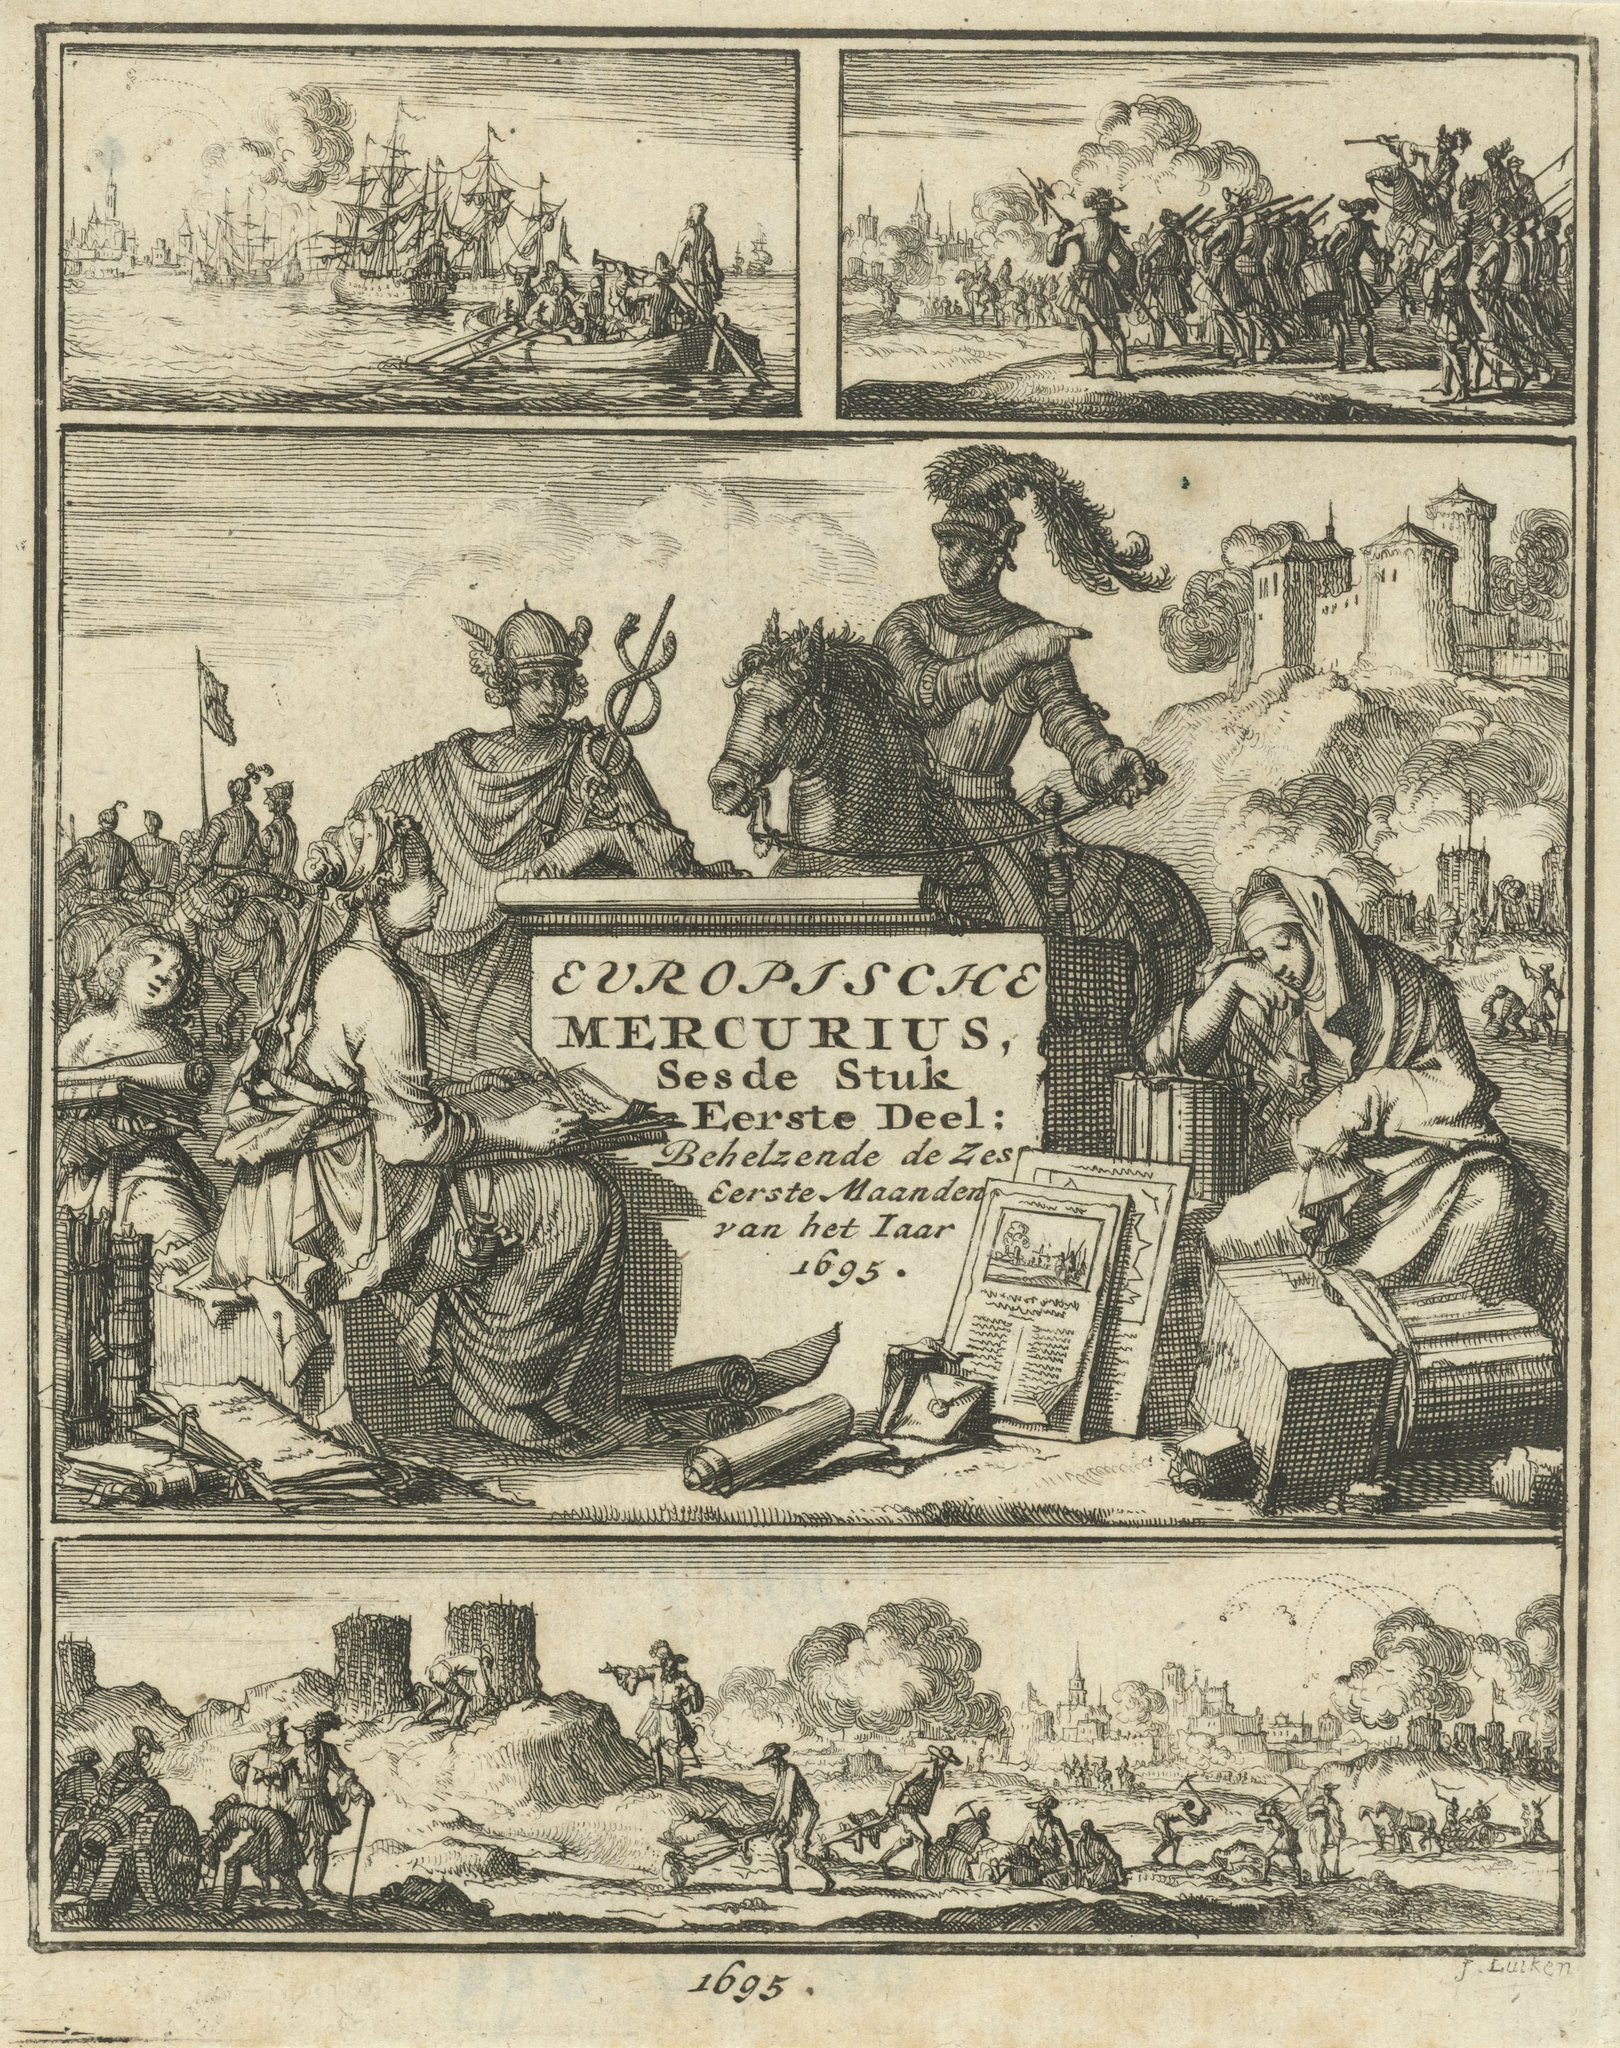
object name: print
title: Titelpagina voor: Europische Mercurius, Sesde Stuk, Eerste Deel: Behelzende de ses Eerste Maenden van het Jaer 1695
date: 1695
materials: paper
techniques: etching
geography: amsterdam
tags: author, poet writing (+ writing), riding a horse, ass, or mule; rider, horseman, (story of) mercury (hermes), attack ~ siege, pain, sorrow, sadness; 'dolore', 'dolore di zeusi' (ripa)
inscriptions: collector's mark: Lugt 2228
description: Mercurius steunend tegen een steen met opschrift, naast hem een krijgsman te paard. Op de voorgrond zit links een vrouw met opengeslagen boek en schrijfveer, rechts een treurende vrouw. Boven deze voorstelling de weergave van een bombardement op een stad vanaf zee (links) en een oprukkend leger richting een belegerde stad (rechts). Onderaan zijn werkzaamheden ter voorbereiding van een aanval weergegeven.